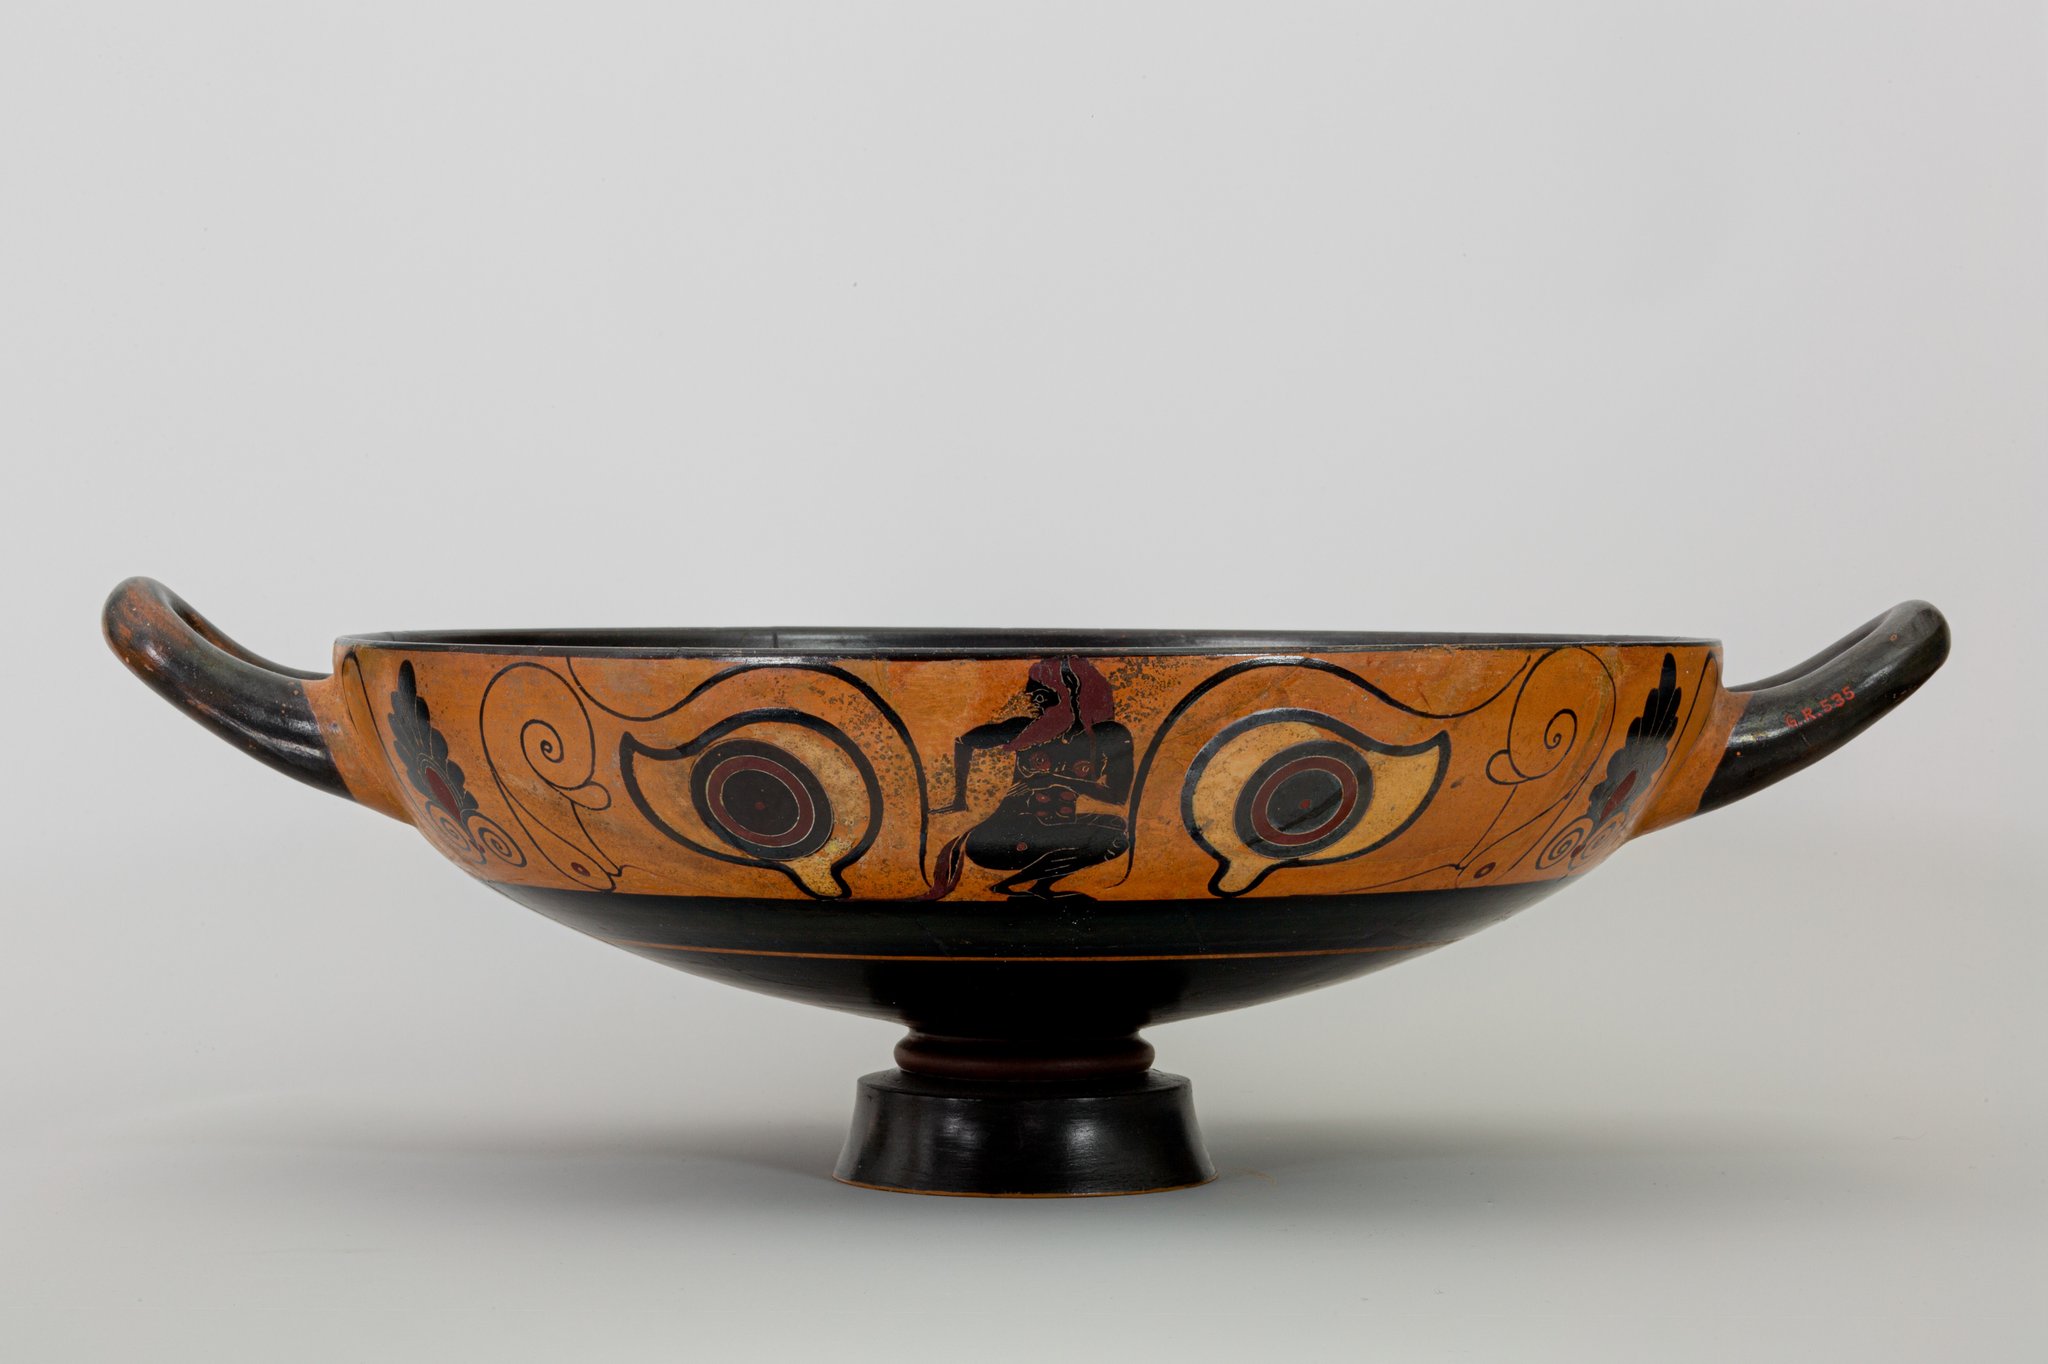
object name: kylix, eye cup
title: Terracotta kylix (drinking cup)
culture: greek, chalcidian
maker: phineus painter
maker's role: artist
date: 525-501 BCE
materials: terracotta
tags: eyes,maenads,satyrs